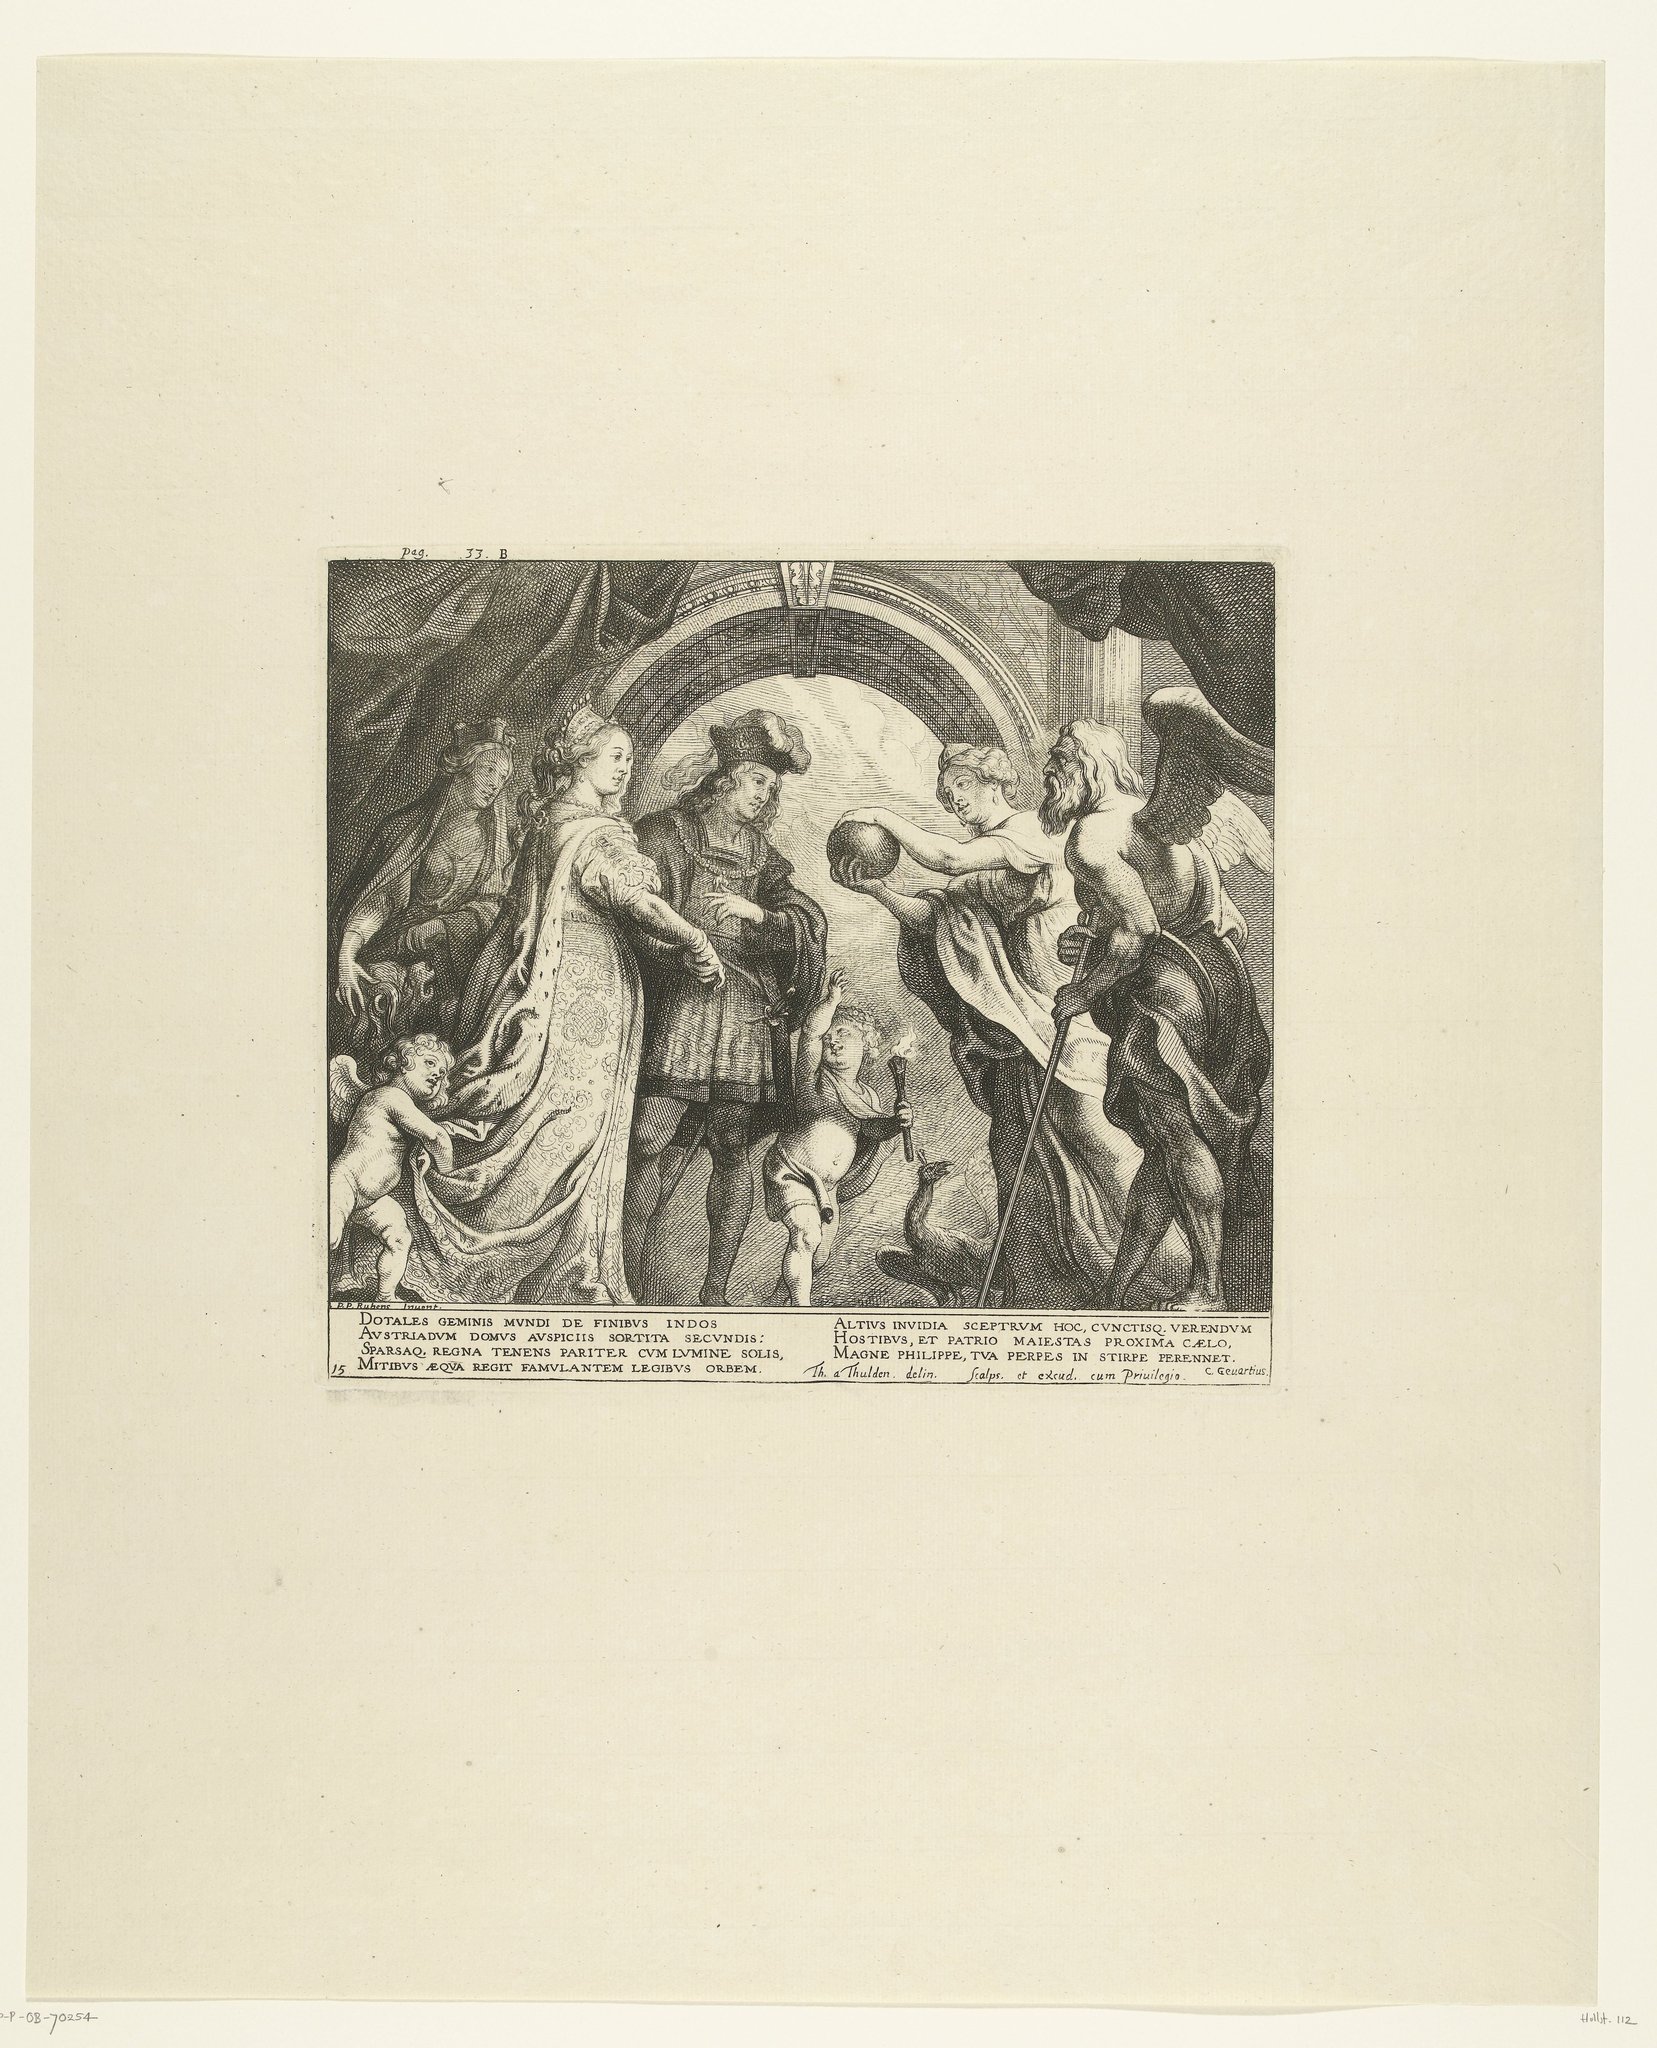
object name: print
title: Conjugium Philippi, Archiducis Austriae, cum Joanna, Hispaniarum Infante: Media Arcus Tab. maiori formâ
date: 1639-1641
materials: paper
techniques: engraving, etching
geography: southern netherlands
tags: bruges, filips de schone (hertog van bourgondië), brussels, landvoogd der zuidelijke nederlanden ferdinand van oostenrijk, triumphal arch, antwerp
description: De centrale voorstelling met het huwelijk tussen Filips de Schone en Johanna van Castilië in 1496. In de achterzijde van de triomfboog van Filips op de hoek van de Huidevetterstraat en de Meir. Gemerkt linksboven: pag. 33B. Blad nr. 15 in een geheel van 43 platen die de uitgave van de beschrijving van de intocht van de Kardinaal Infant Ferdinand van Oostenrijk te Antwerpen op 17 april 1635 als de nieuwe landvoogd voor de Spaanse Nederlanden illustreren.